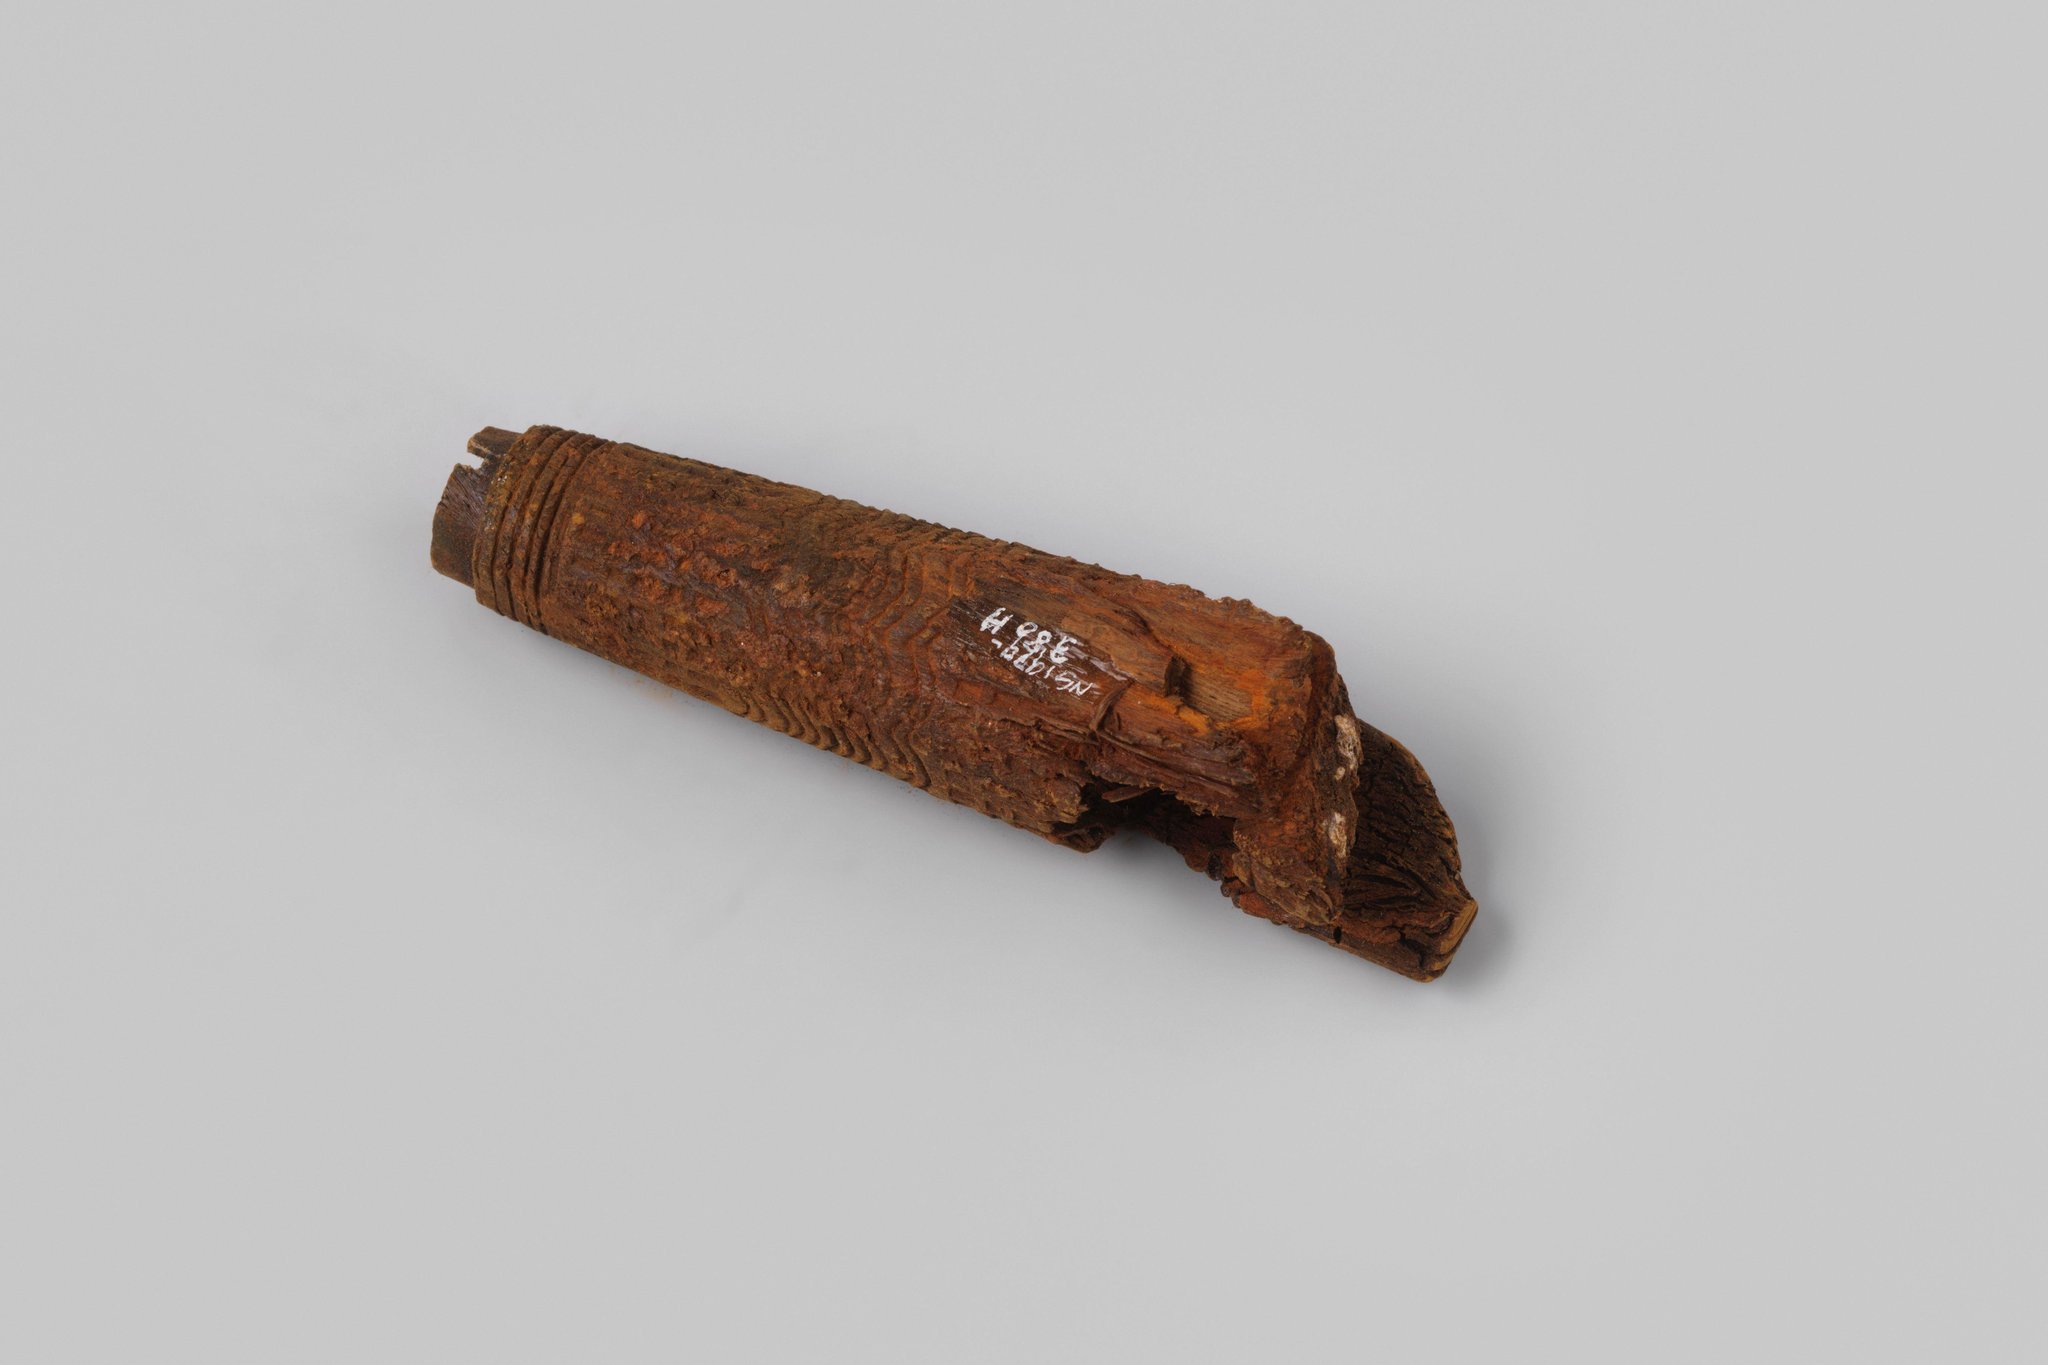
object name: knife handle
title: Fragment messenheft uit het wrak van de Oost-Indiëvaarder Hollandia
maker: Anonymous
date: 1700-1743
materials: wood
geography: netherlands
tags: verenigde oostindische compagnie, hollandia (schip), annet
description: Knife, handle, cylindrical: tapering; id. NG 1979-403H, ferrules id. NG 1980-27H426.